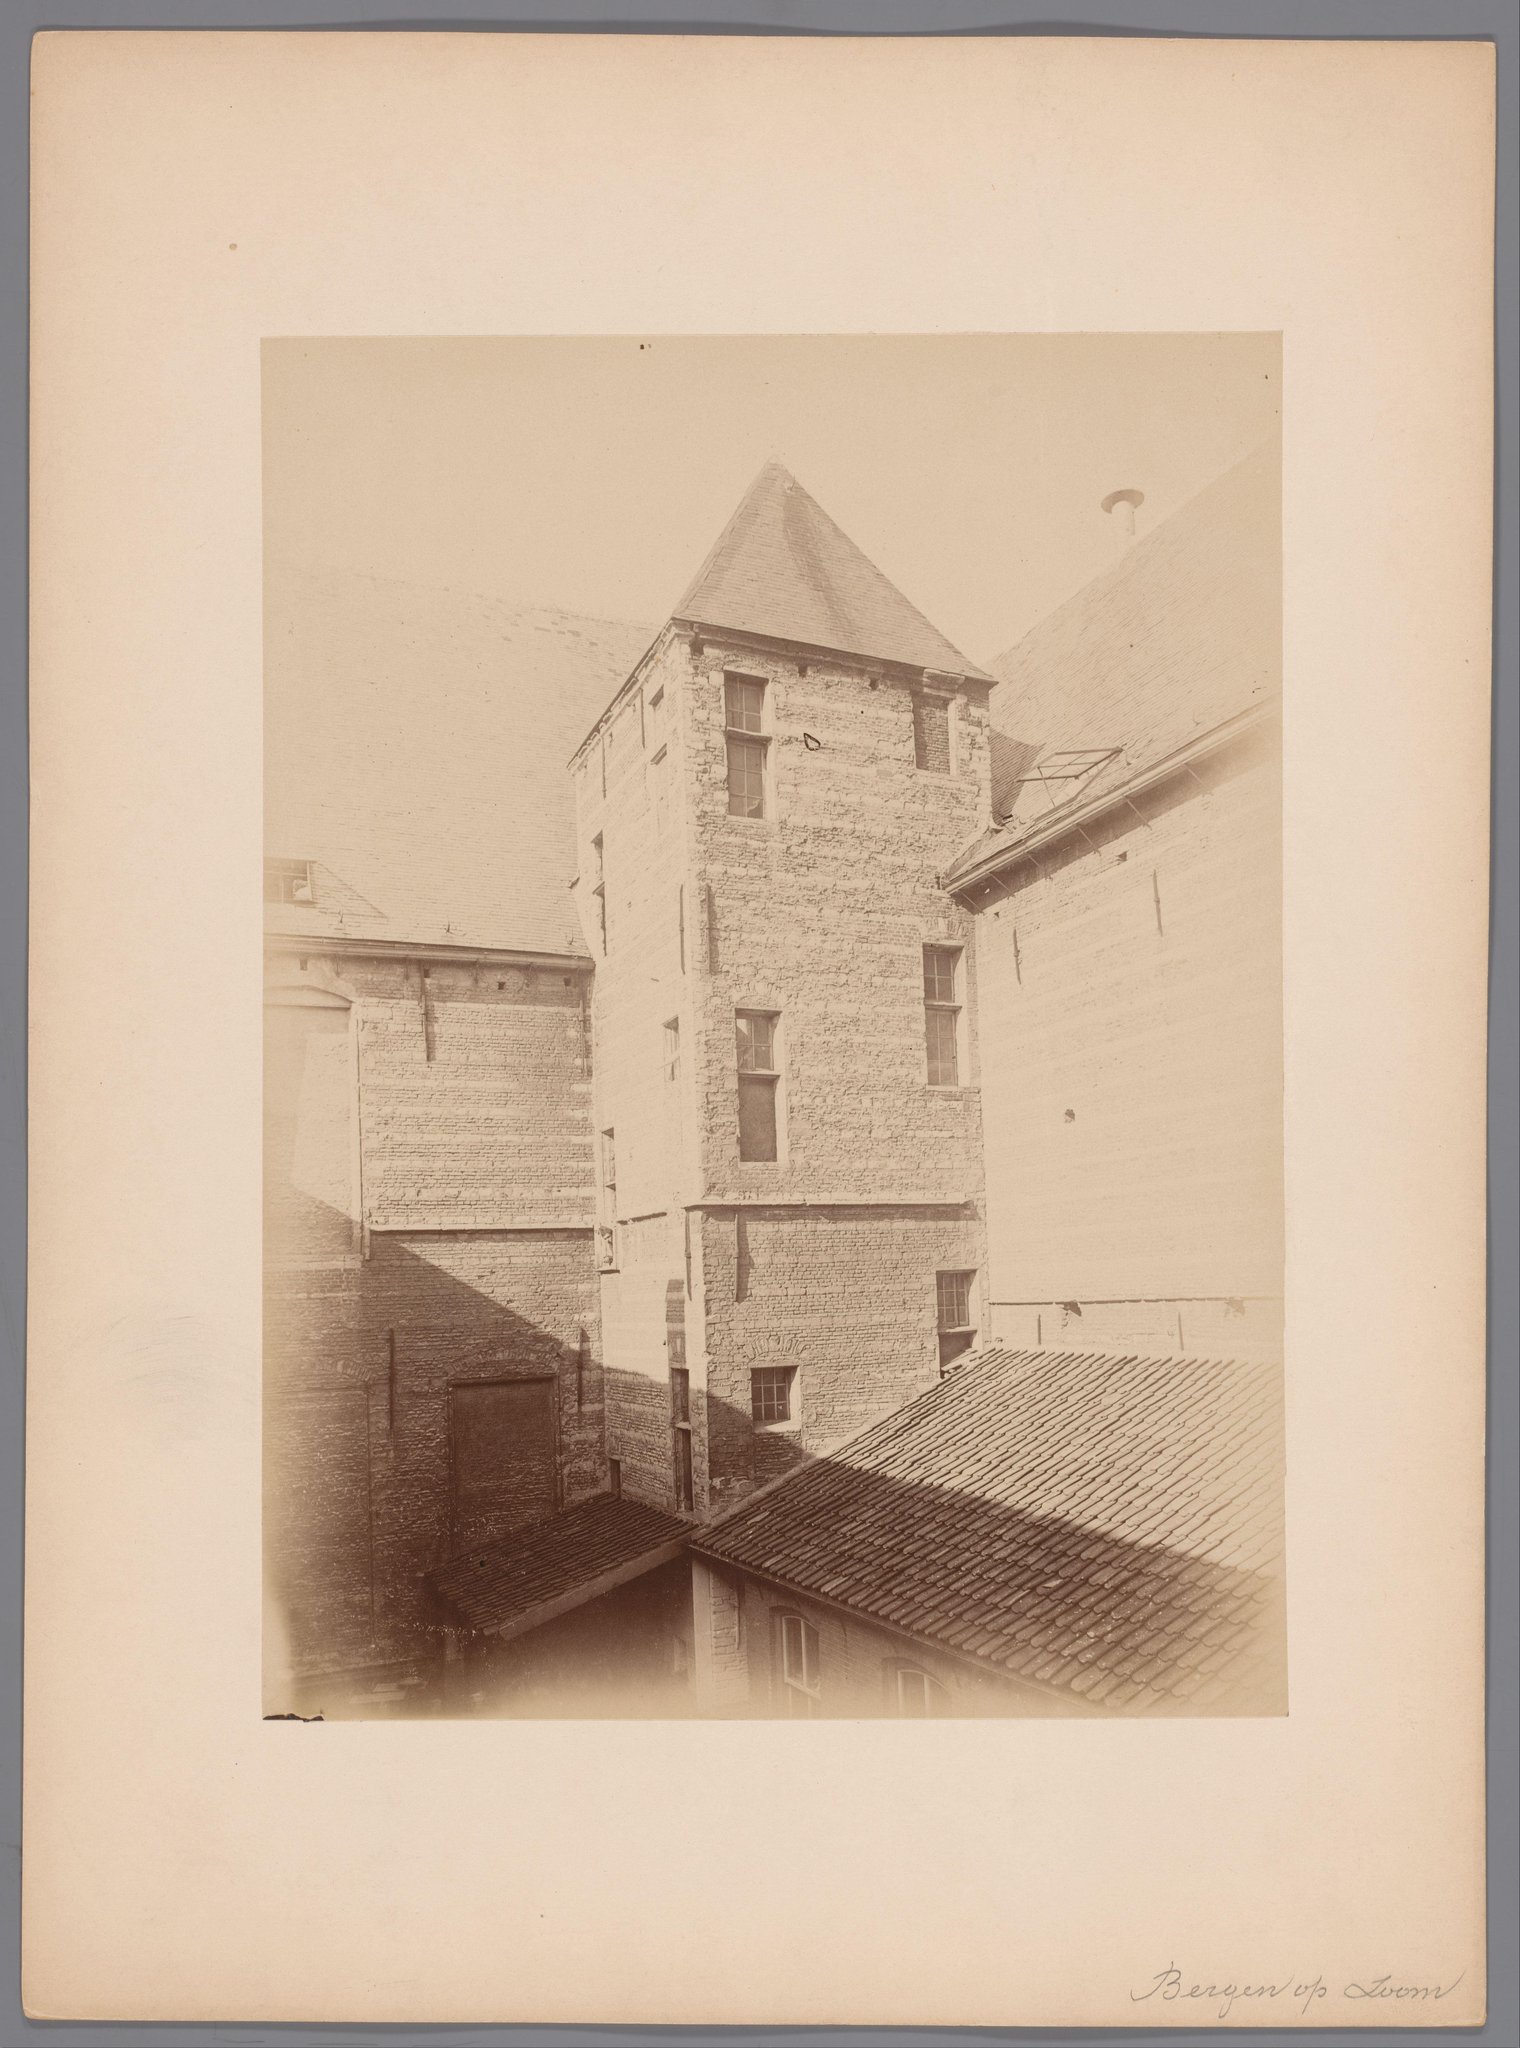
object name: photograph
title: Toren op de binnenplaats van het Markiezenhof te Bergen op Zoom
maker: anoniem (monumentenzorg)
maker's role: fotograaf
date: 1890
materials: cardboard, photographic support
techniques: albumen print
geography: markiezenhof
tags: courtyard, tower (of house or building)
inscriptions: annotation: ‘Bergen op Zoom’, annotation: ‘Markiezenhof te Bergen-op-Zoom/ gezicht op de kleine binnenplaats/ sept 1890’